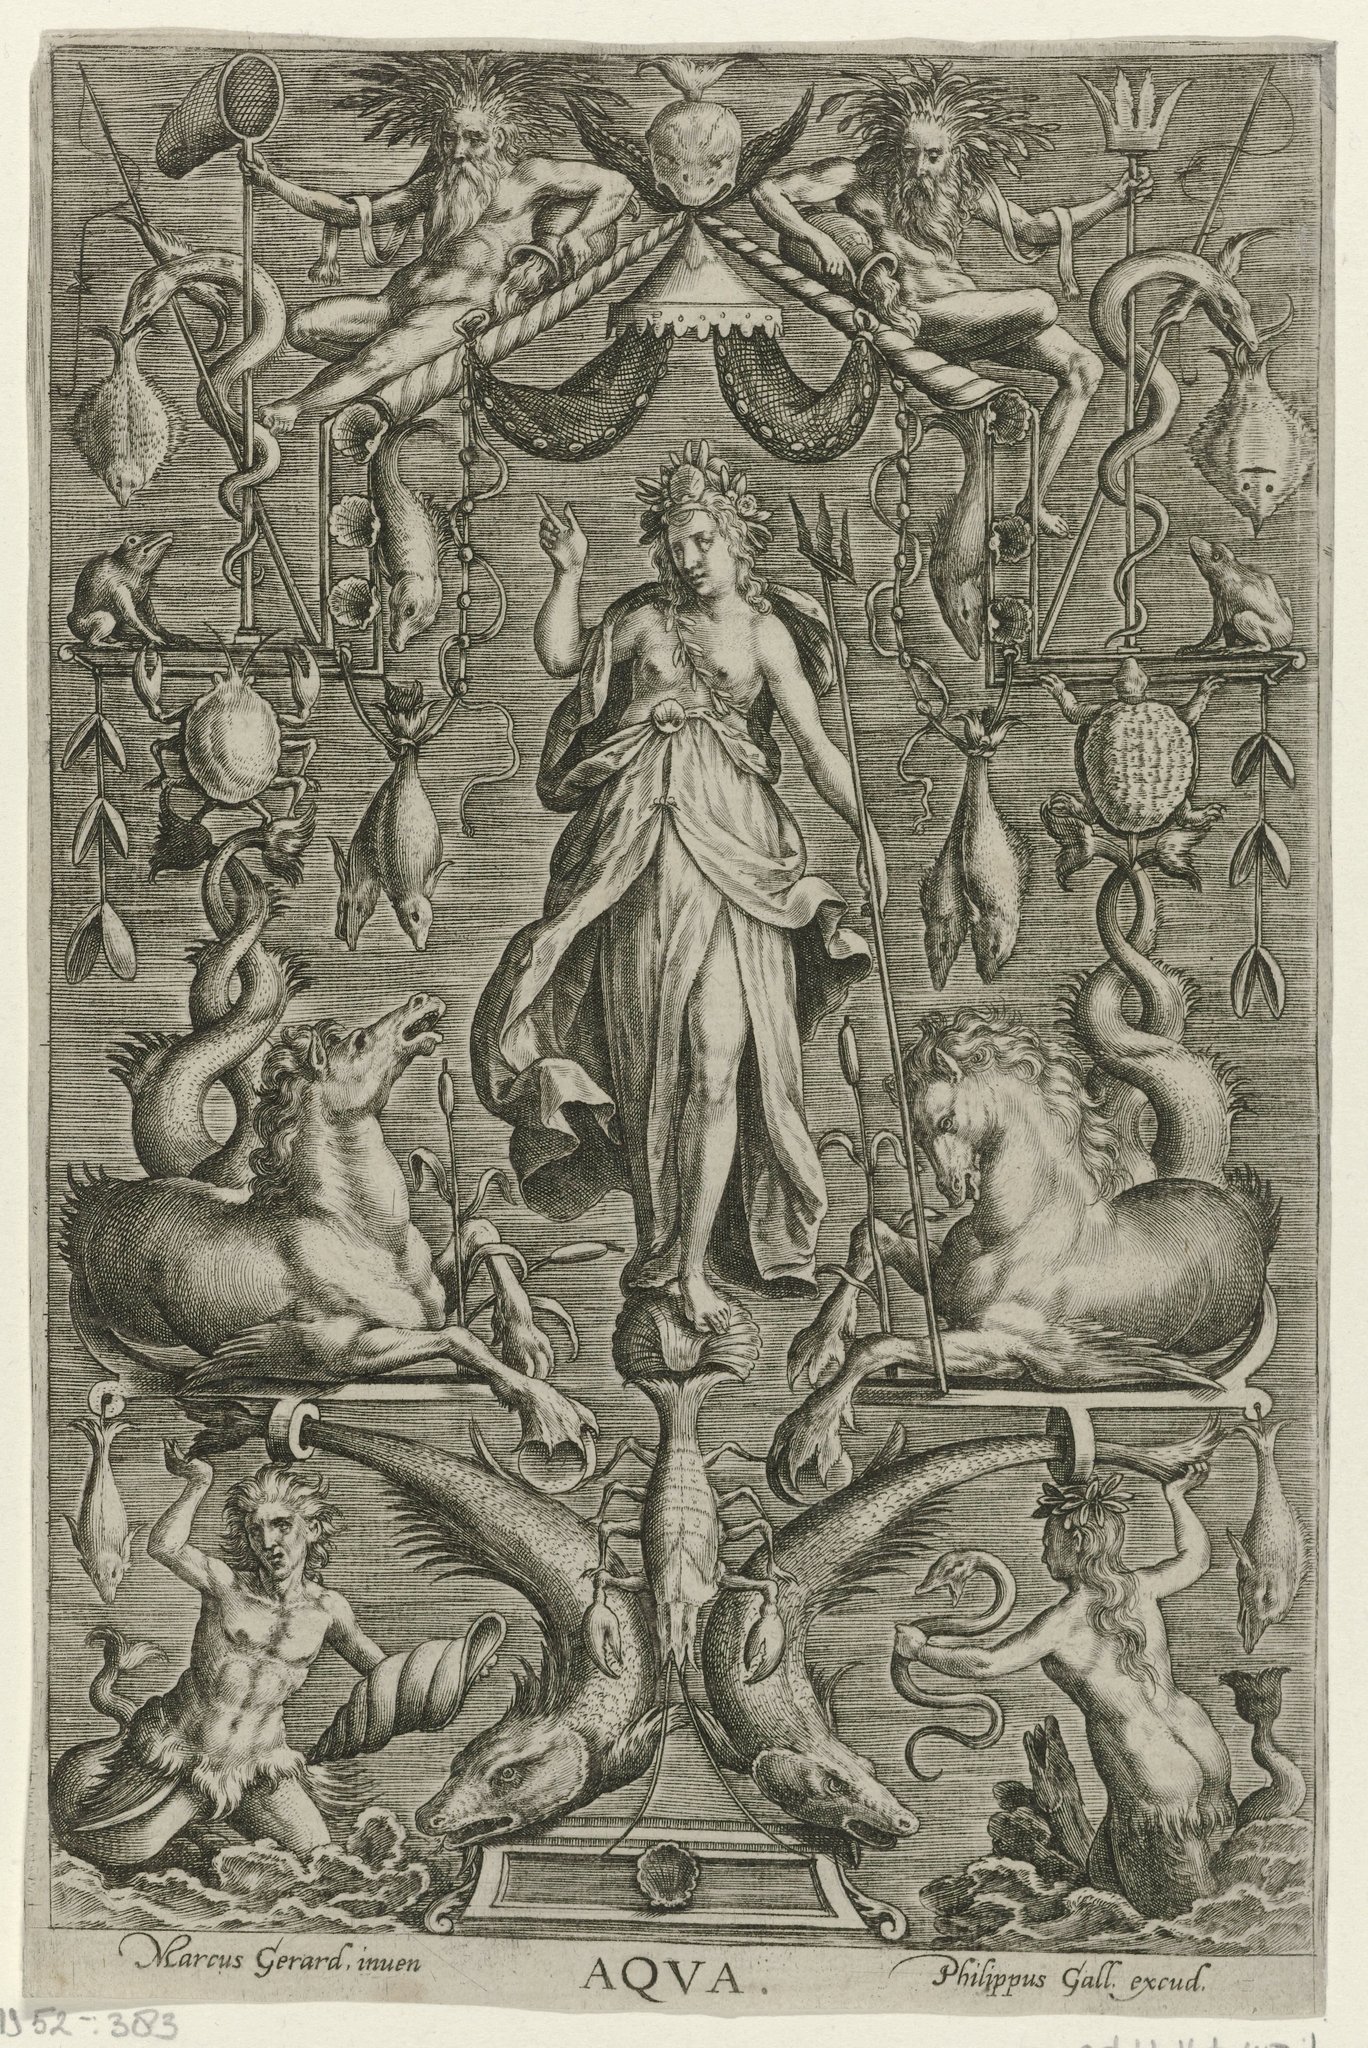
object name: print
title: Water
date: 1547-1622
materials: paper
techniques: engraving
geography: antwerp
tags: ornament ~ arabesque, water (one of the four elements)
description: De personificatie van Water, omringd door ornamentele versieringen. Ze heeft een drietand in haar hand en wordt geflankeerd door twee zeepaarden. In de vier hoeken van de prent vier meermannen. De prent is deel van een reeks over de vier elementen.